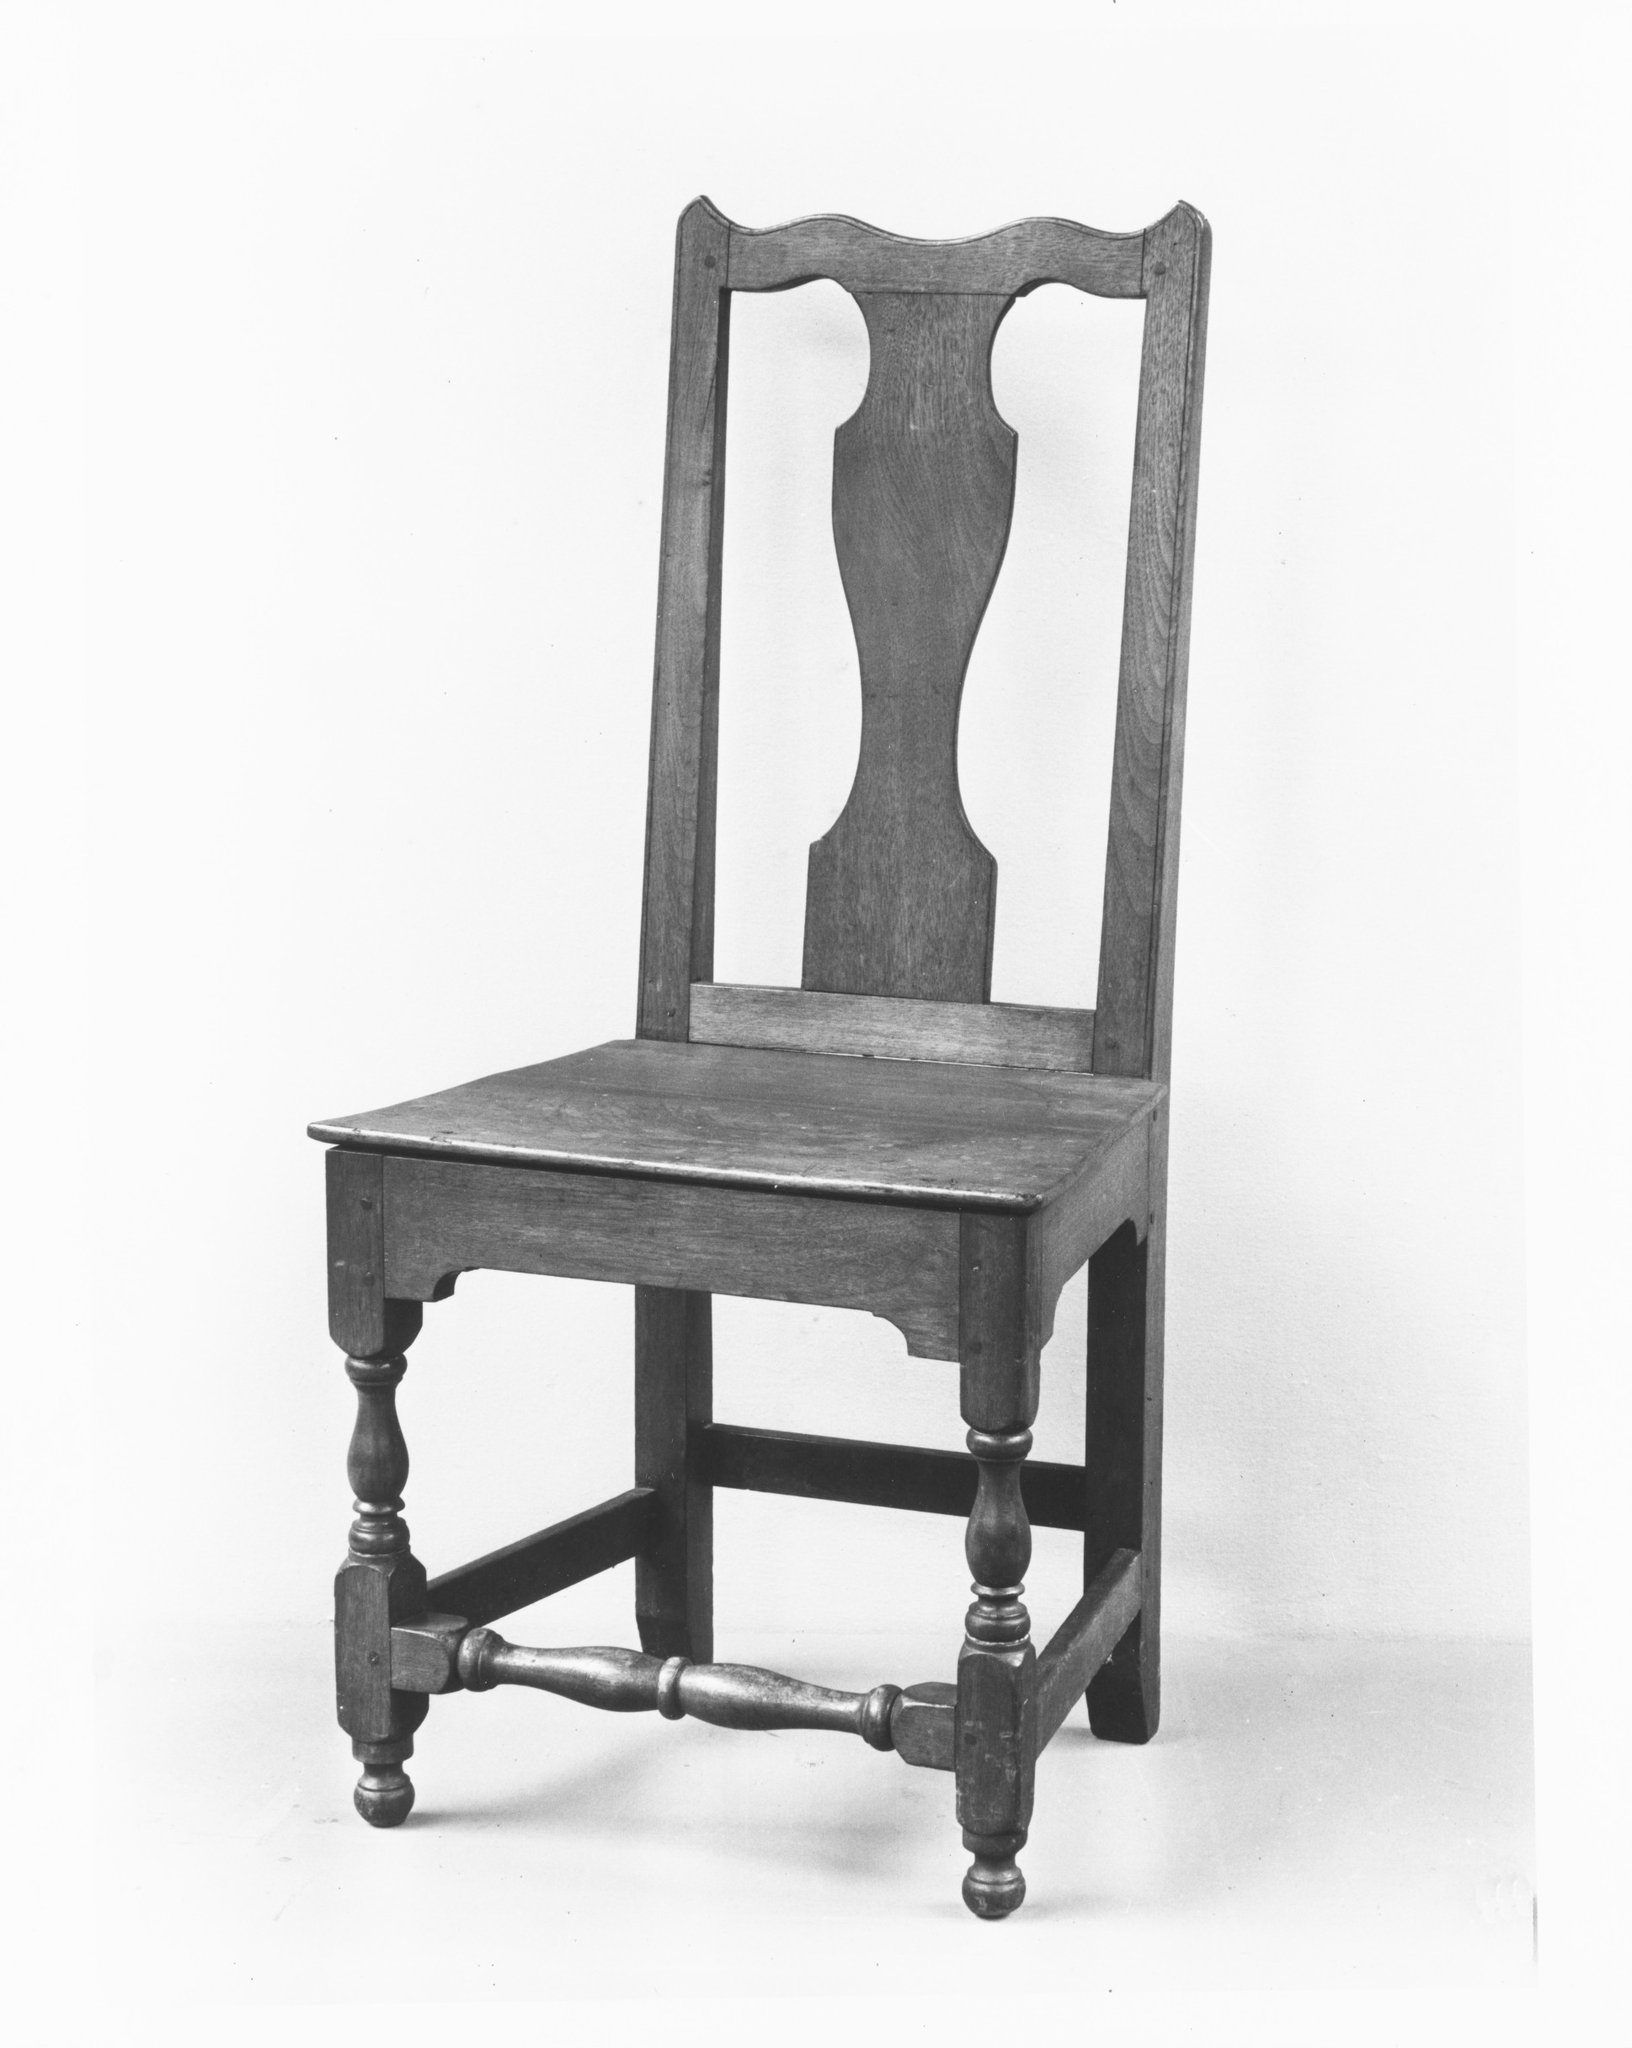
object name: side chair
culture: american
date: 1740-1780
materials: wood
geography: united states